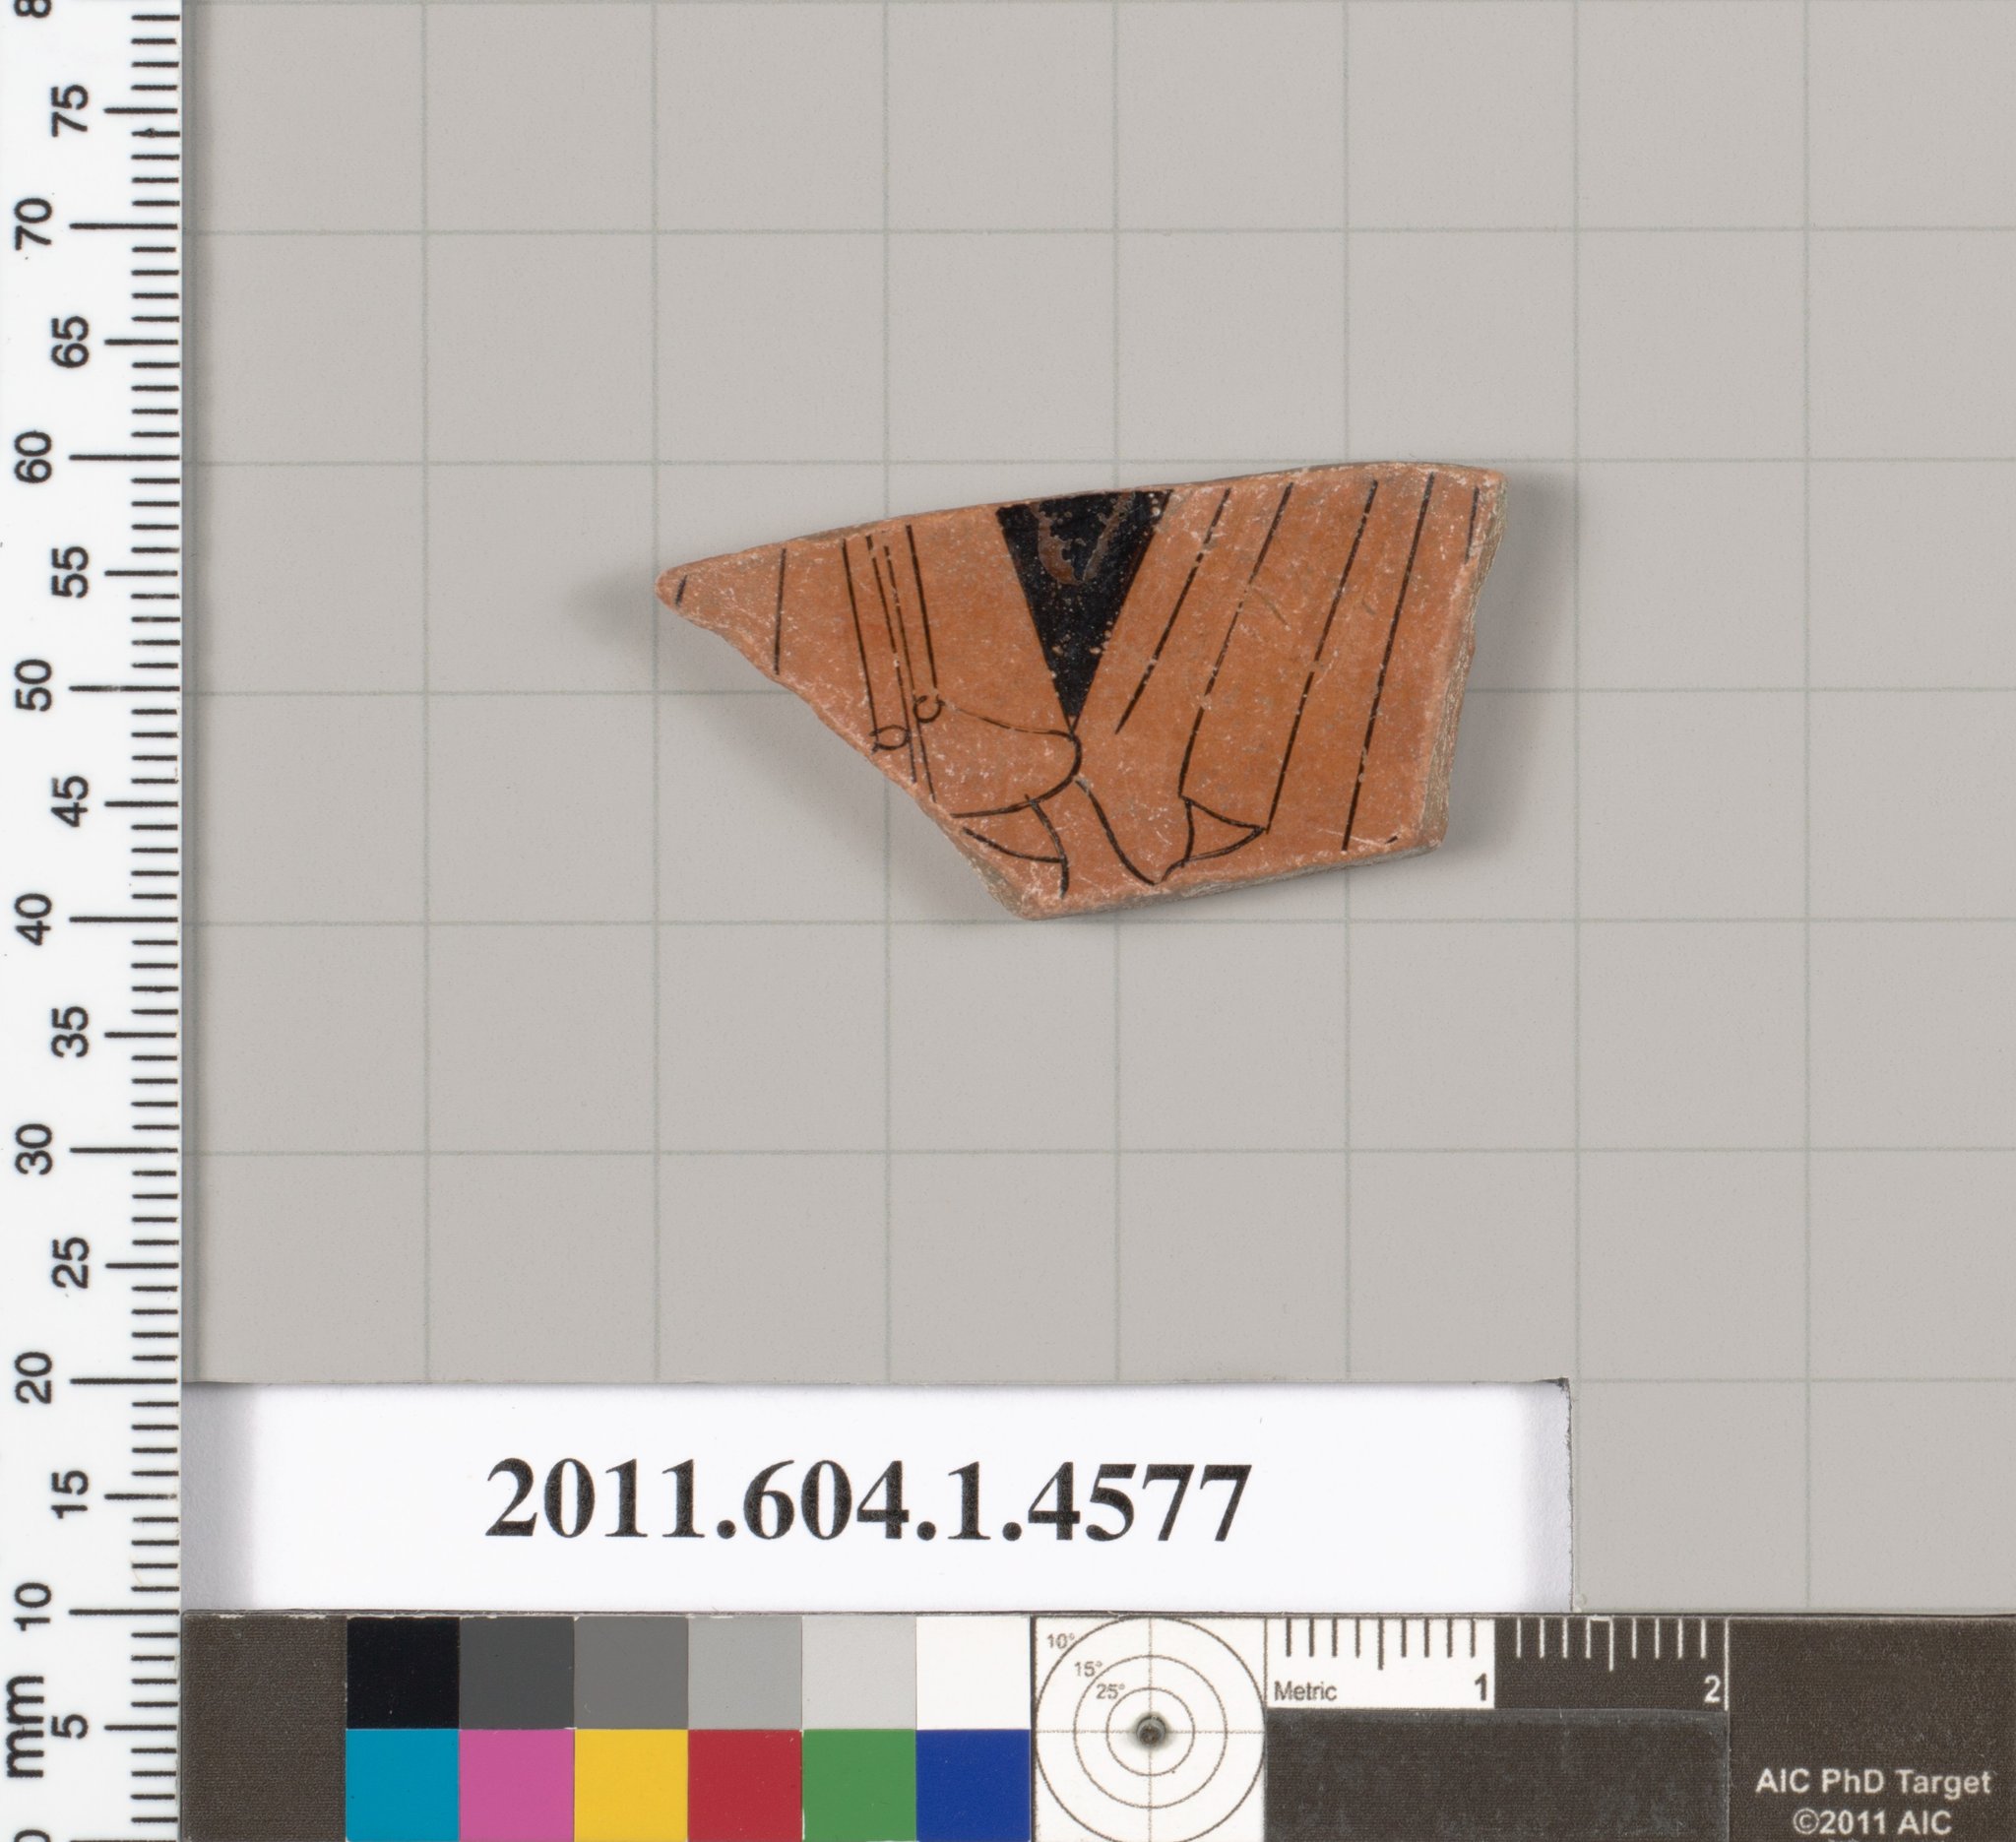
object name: kylix fragment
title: Terracotta fragment of a kylix (drinking cup)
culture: greek, attic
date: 500-470 BCE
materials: terracotta